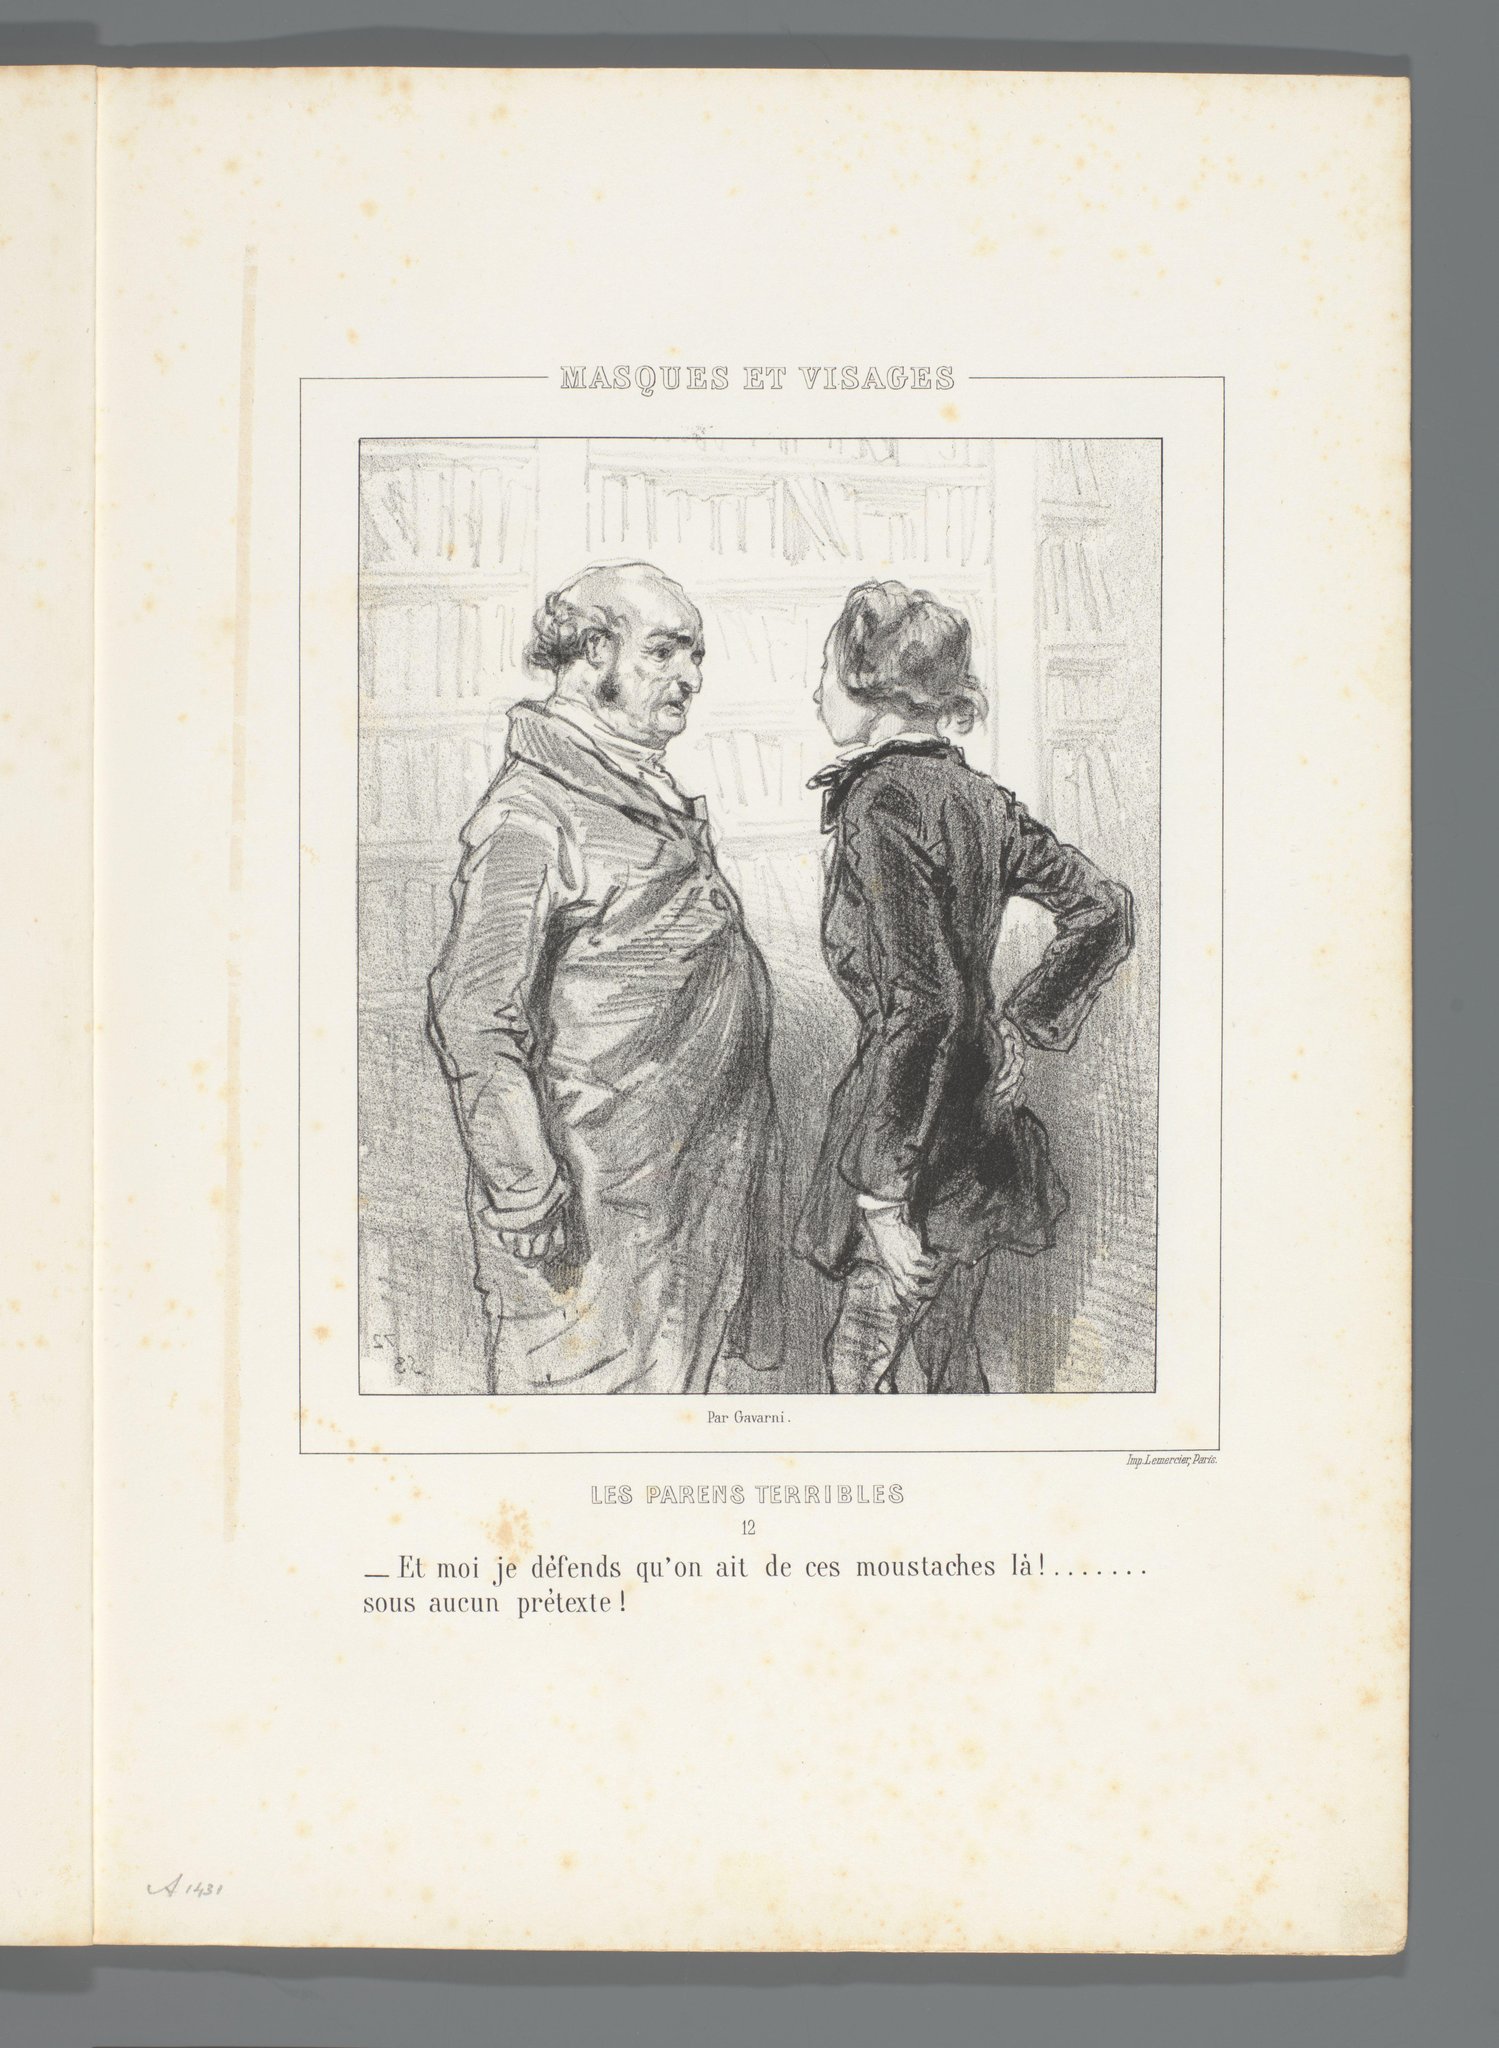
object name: cartoon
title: Verschrikkelijke ouders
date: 1853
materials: paper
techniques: lithograph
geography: paris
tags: parents with their children, moustache, father and son(s) (family group) (with number of sons)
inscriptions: collector's mark: Lugt 2228a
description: Prent gebruikt voor: Paris (Journal), 14 april 1853.